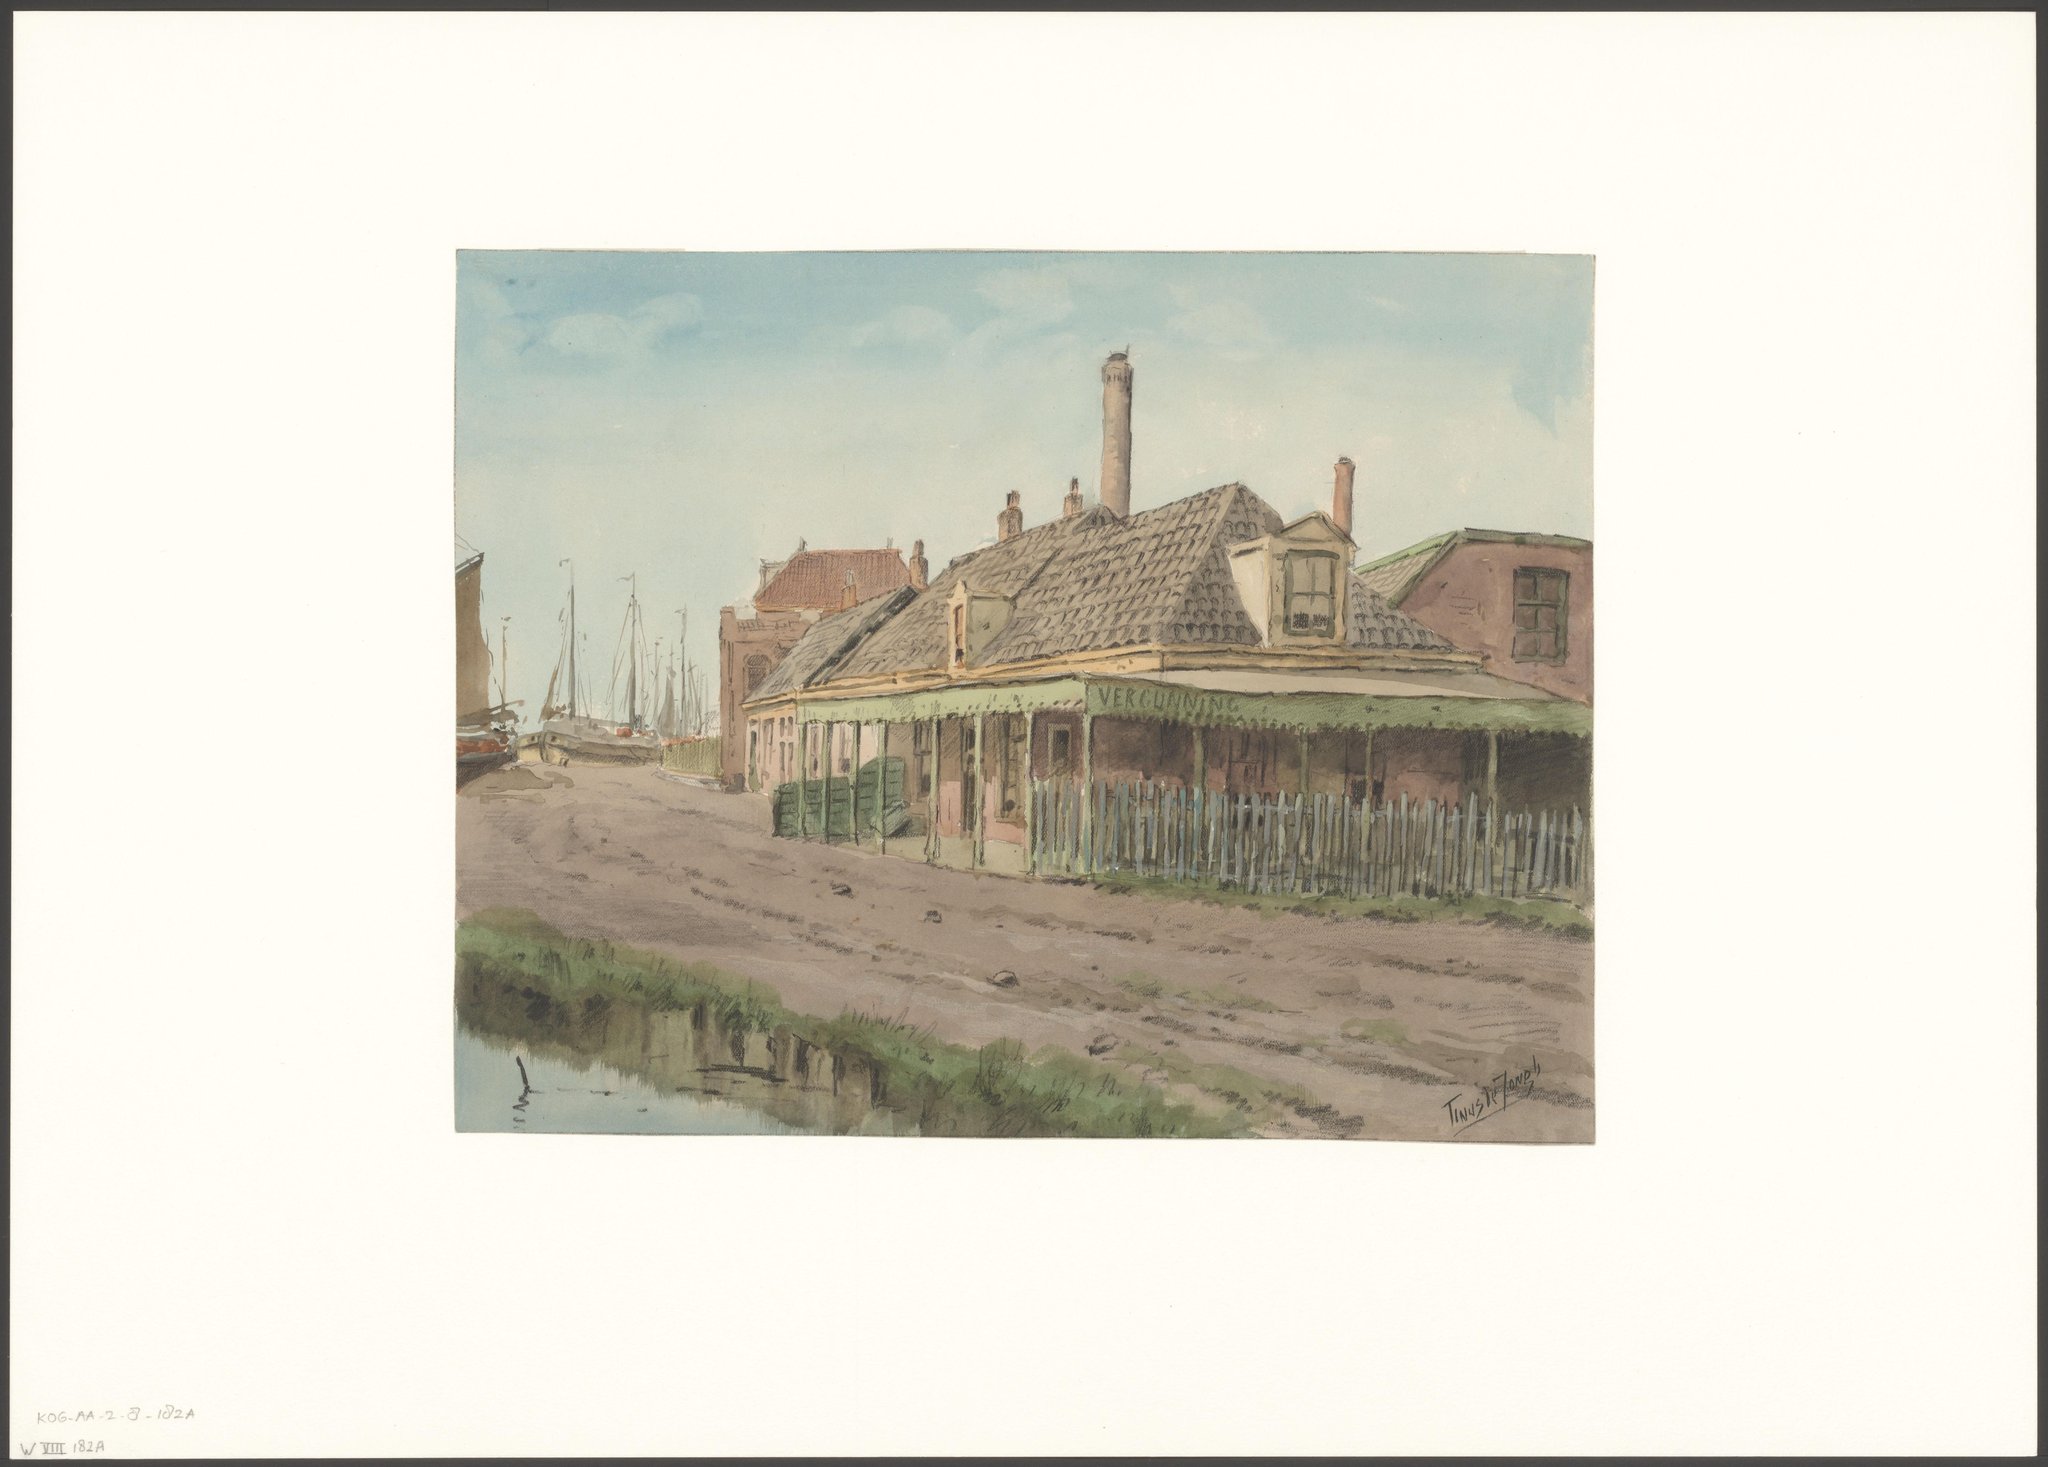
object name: drawing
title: Gezicht op enkele gebouwen aan de Omval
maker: tinus de jongh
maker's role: print maker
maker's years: 1885-1942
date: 1919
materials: chalk, gouache, paper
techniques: brush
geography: amsterdam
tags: city-view in general; 'veduta', road, path, farm or solitary house in landscape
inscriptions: signature: ‘TinusdeJongh’, collector's mark: Lugt 800a, signature and date: ‘14 maart 1919. / "TinusdeJongh"’, inscription: ‘[...]de Visschers huisje aan den Omval’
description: Tekening binnen de Atlas Van Eck ingedeeld op wijknummer 8.